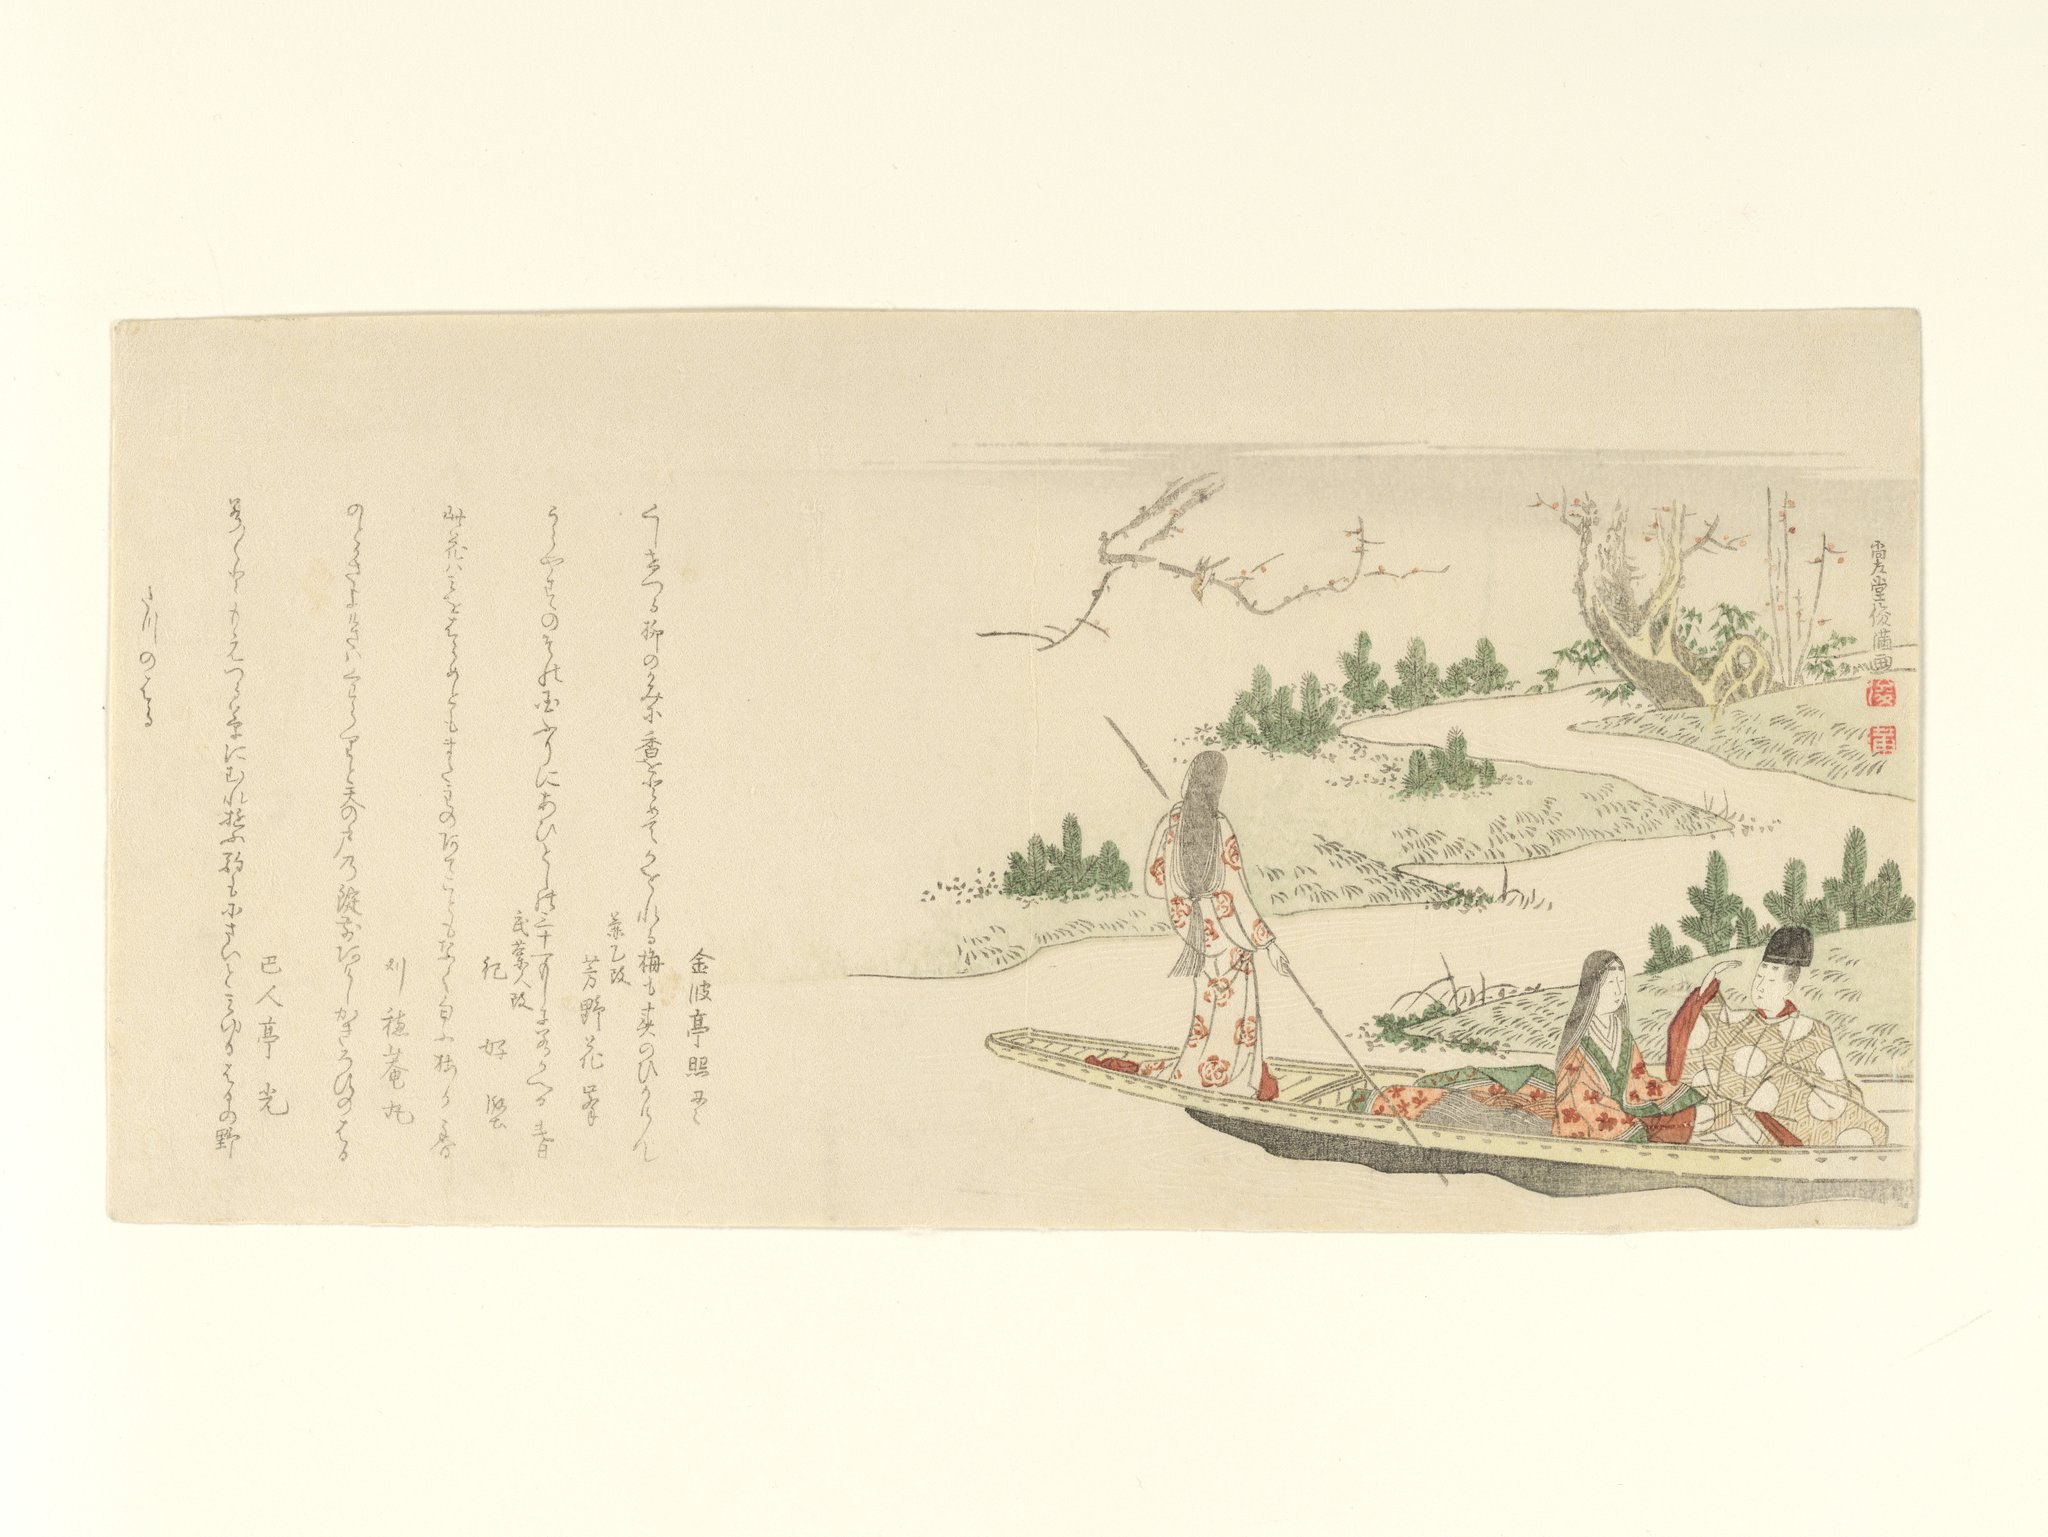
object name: print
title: Courtier and Lady with a Young Woman Poling a Boat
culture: japanese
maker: kubo shunman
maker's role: artist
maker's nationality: japanese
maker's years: 1757-1820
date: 1796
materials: ink, paper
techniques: surimono, woodblock print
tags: men,women,trees,boats